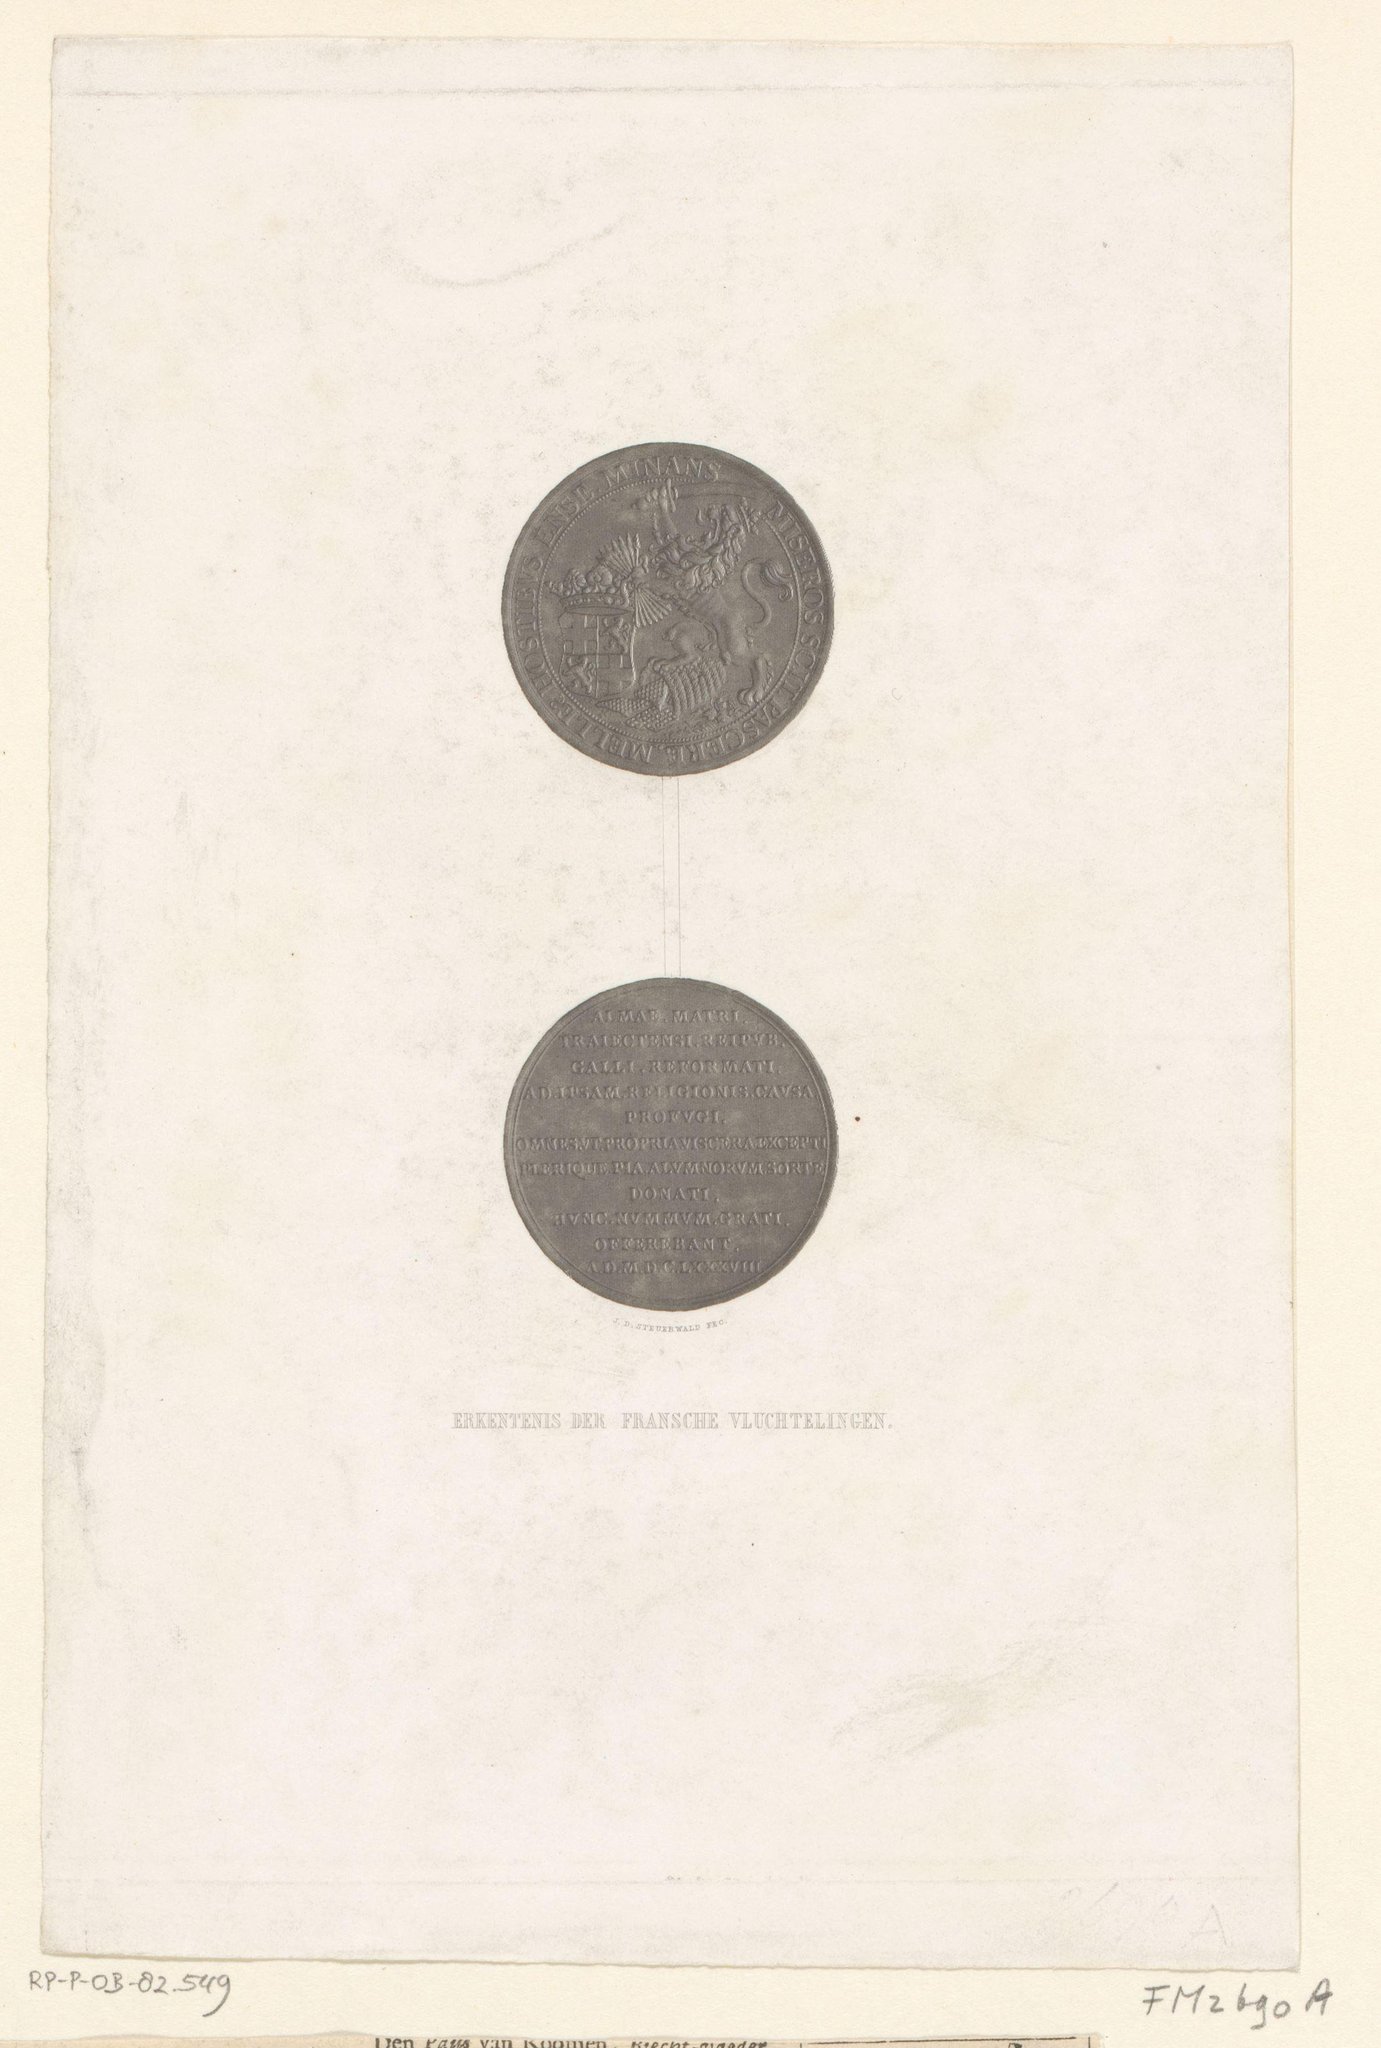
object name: print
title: Erkentenis der Fransche vluchtelingen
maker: jan dam steuerwald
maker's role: print maker, printer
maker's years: 1805-1869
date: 1844-1846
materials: paper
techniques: engraving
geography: low countries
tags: medal (considered as a piece of sculpture, regardless of its specific function), utrecht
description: Gebruikt als illustratie in: Koenen, Geschied. der Fransche vlugtelingen, in: Nieuwe reeks van werken van de Maatschappij der Nederlandsche Letterkunde te Leiden, Brill, Leiden, dl. I (1846).